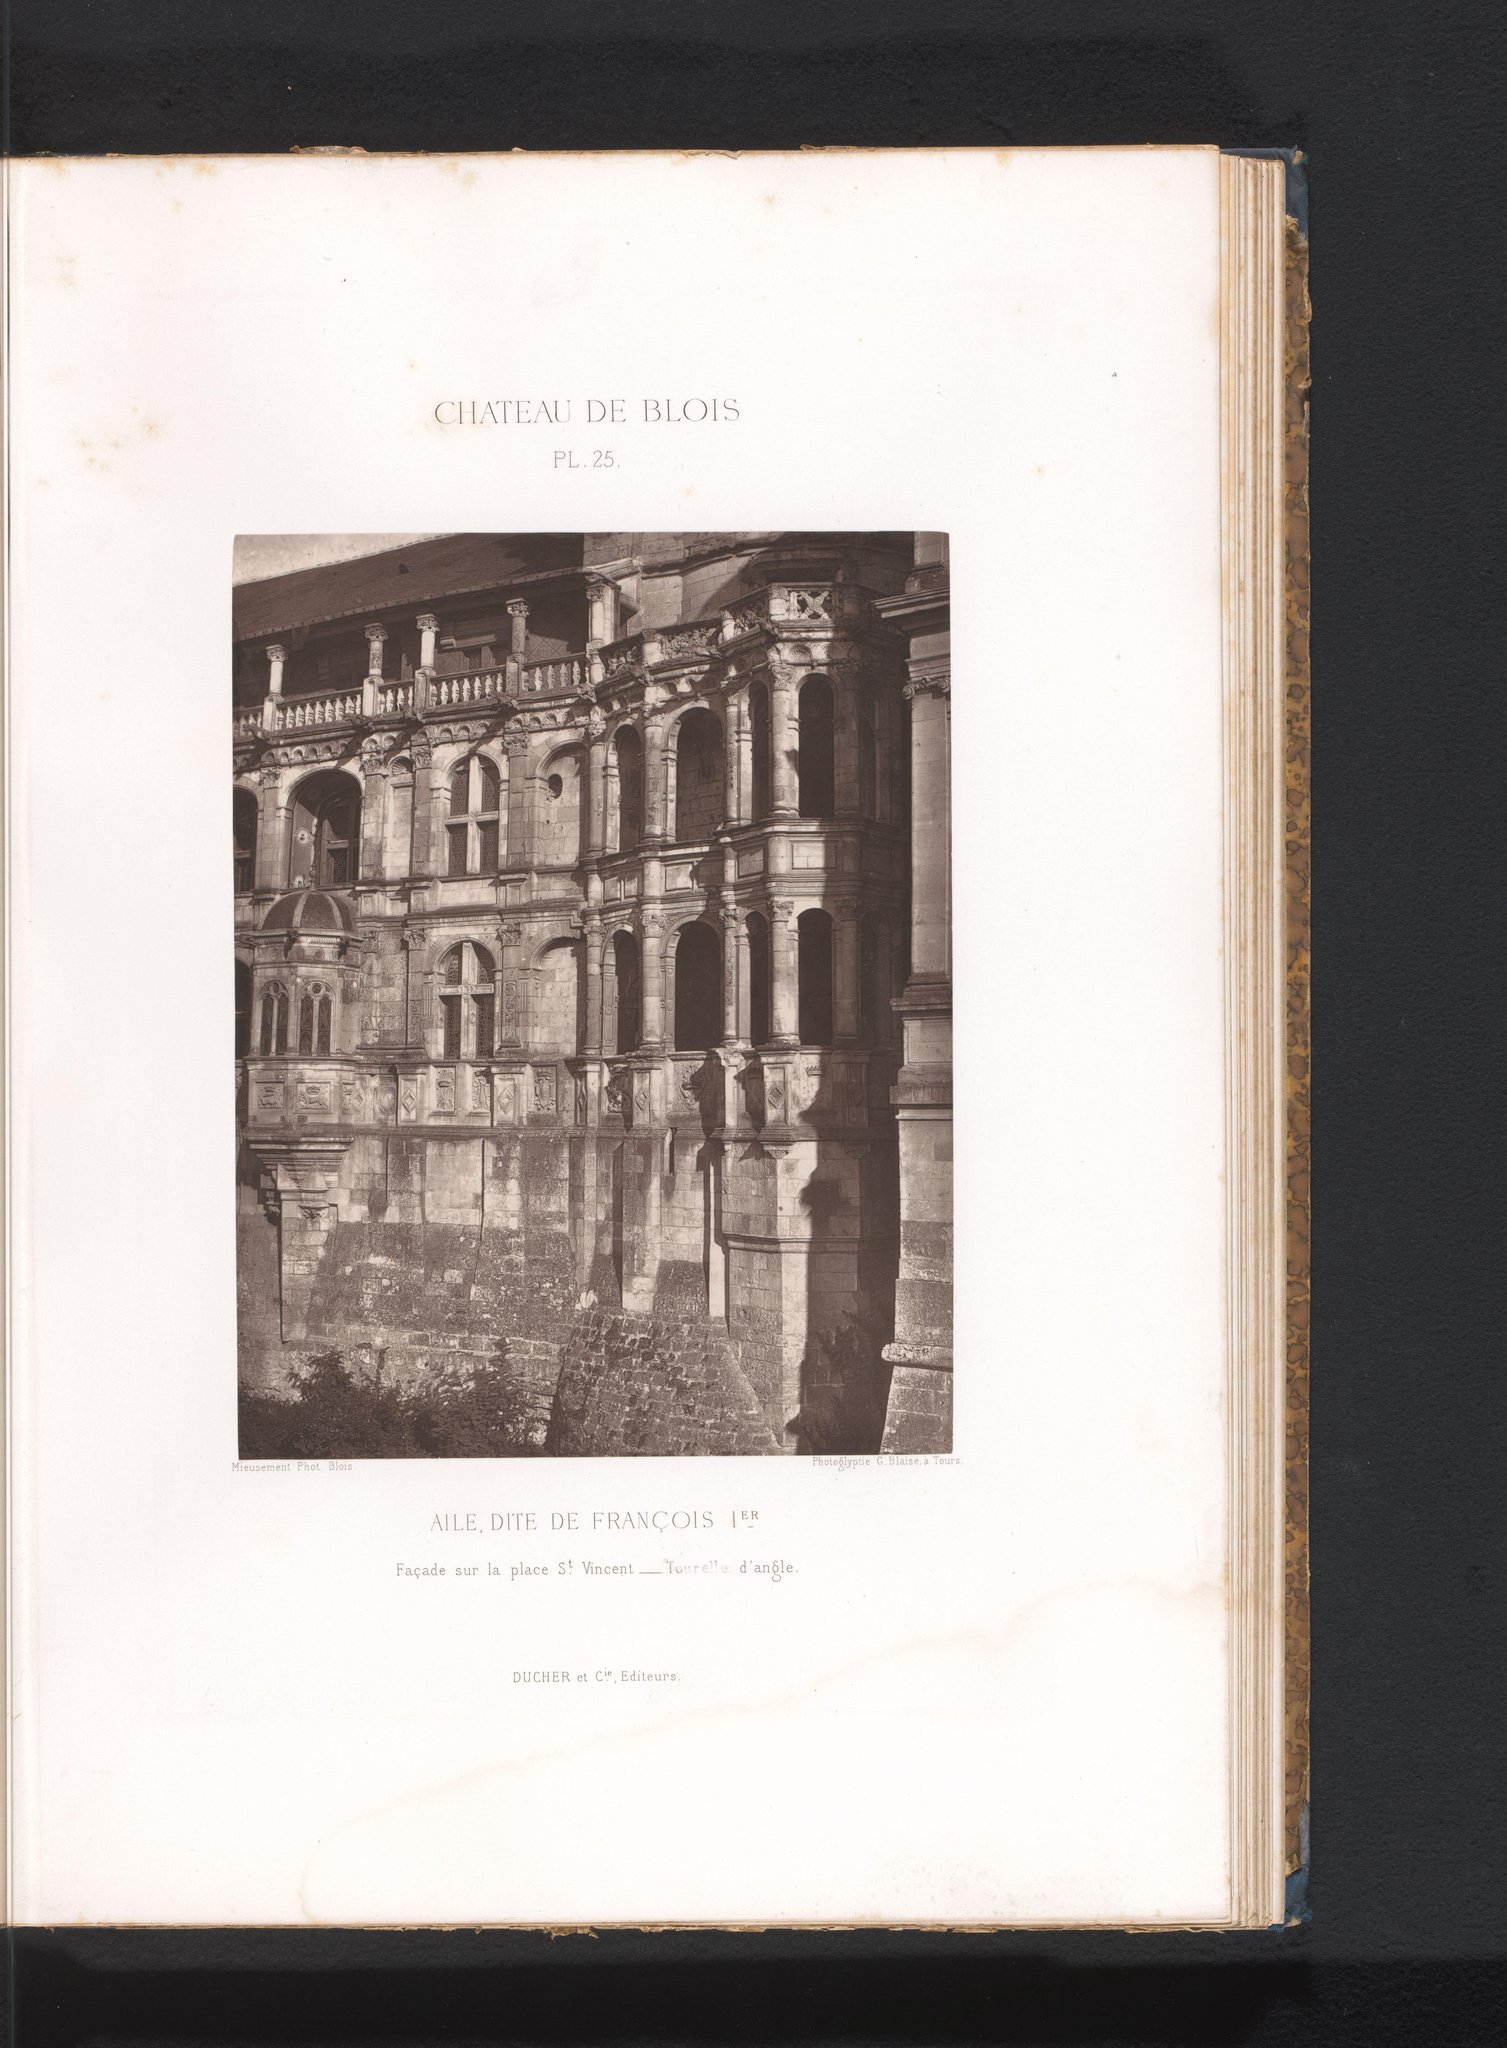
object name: photomechanical print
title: Chateau de Blois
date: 1870-1875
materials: paper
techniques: woodburytype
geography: tours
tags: castle, tower (of house or building)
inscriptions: number: ‘PL. 25.’